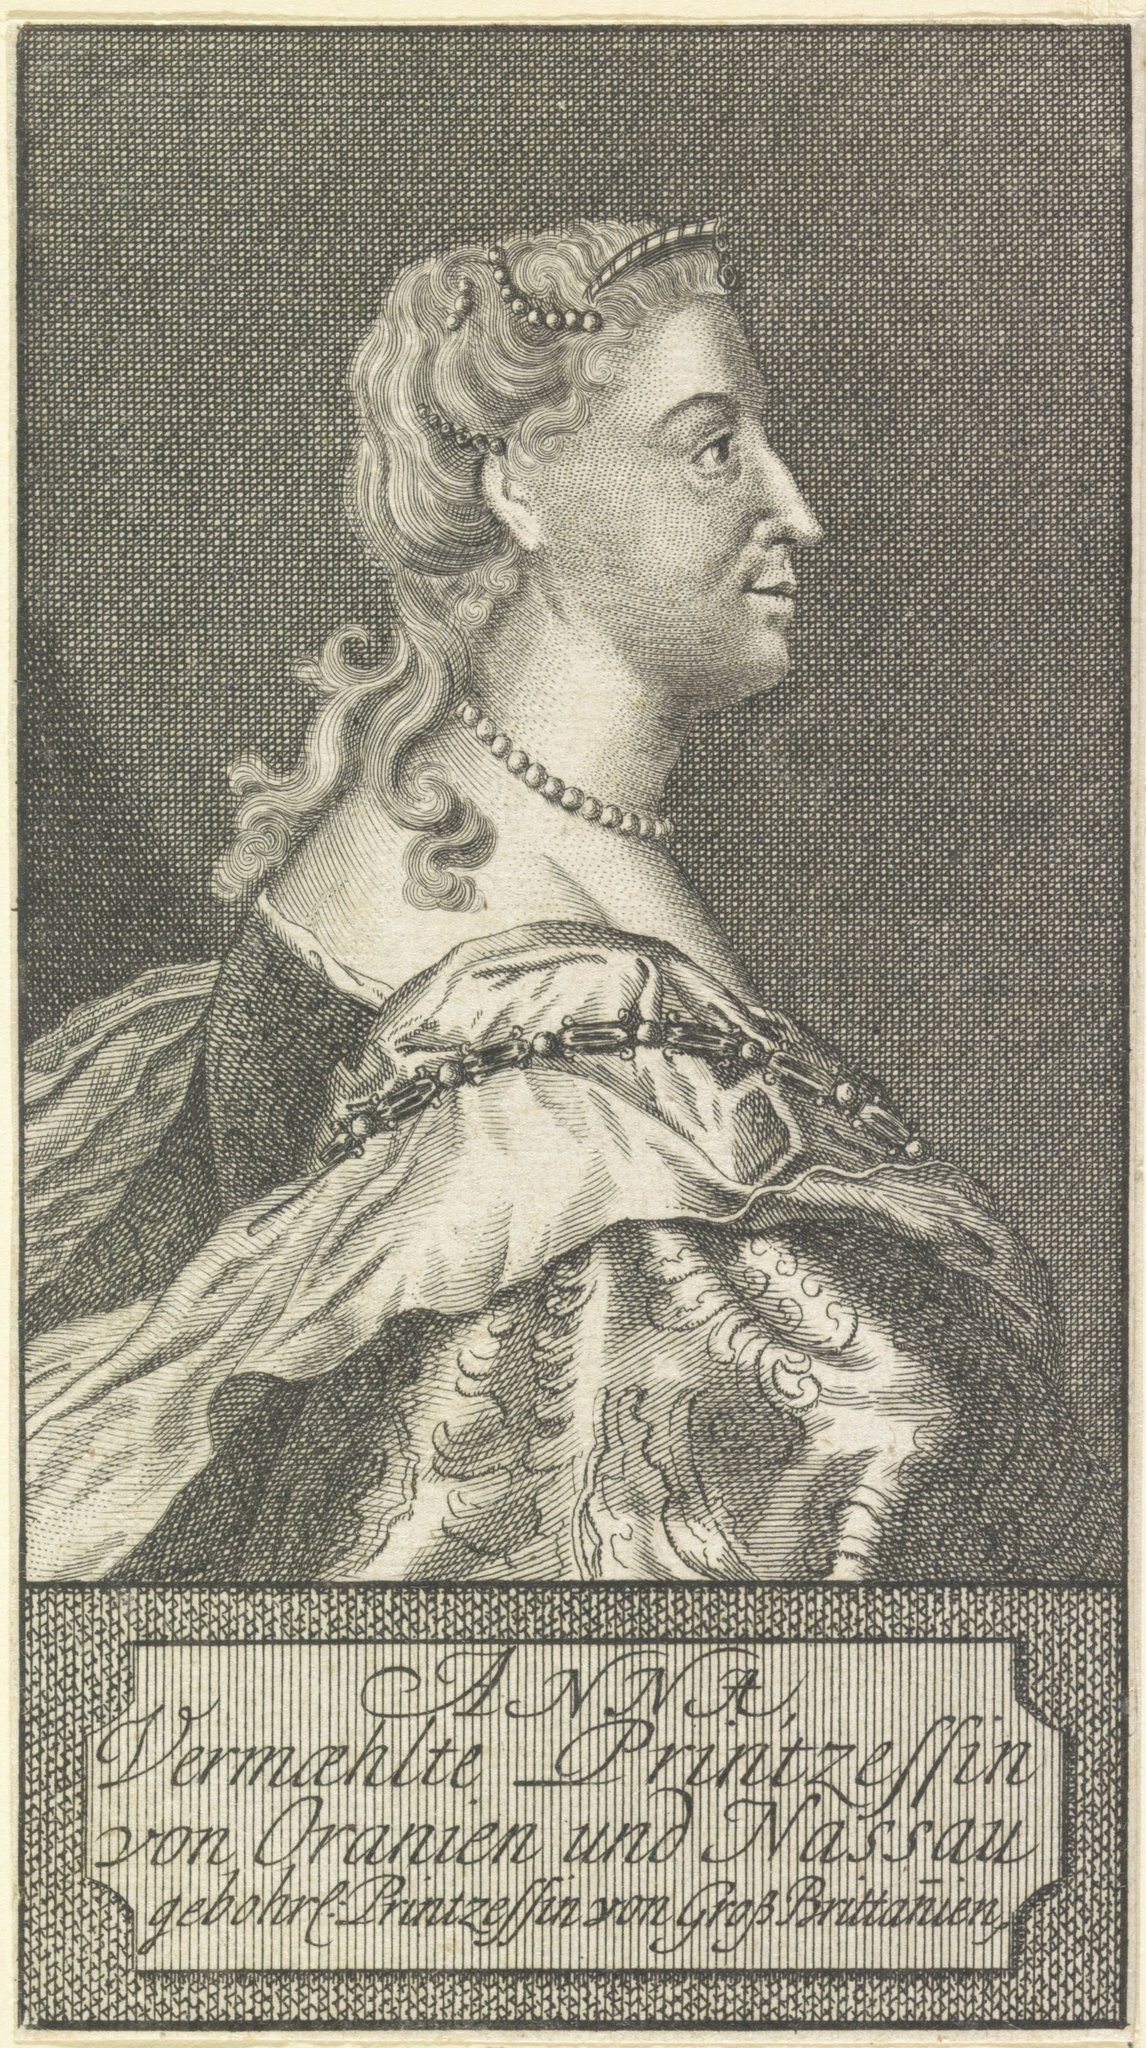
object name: print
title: Portret van Anna van Hannover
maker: Anonymous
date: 1734-1799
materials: paper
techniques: engraving, etching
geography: low countries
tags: the hague, anna van hannover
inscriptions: collector's mark: Lugt 2228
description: Portret van Anna. In een kader haar naam en titels.